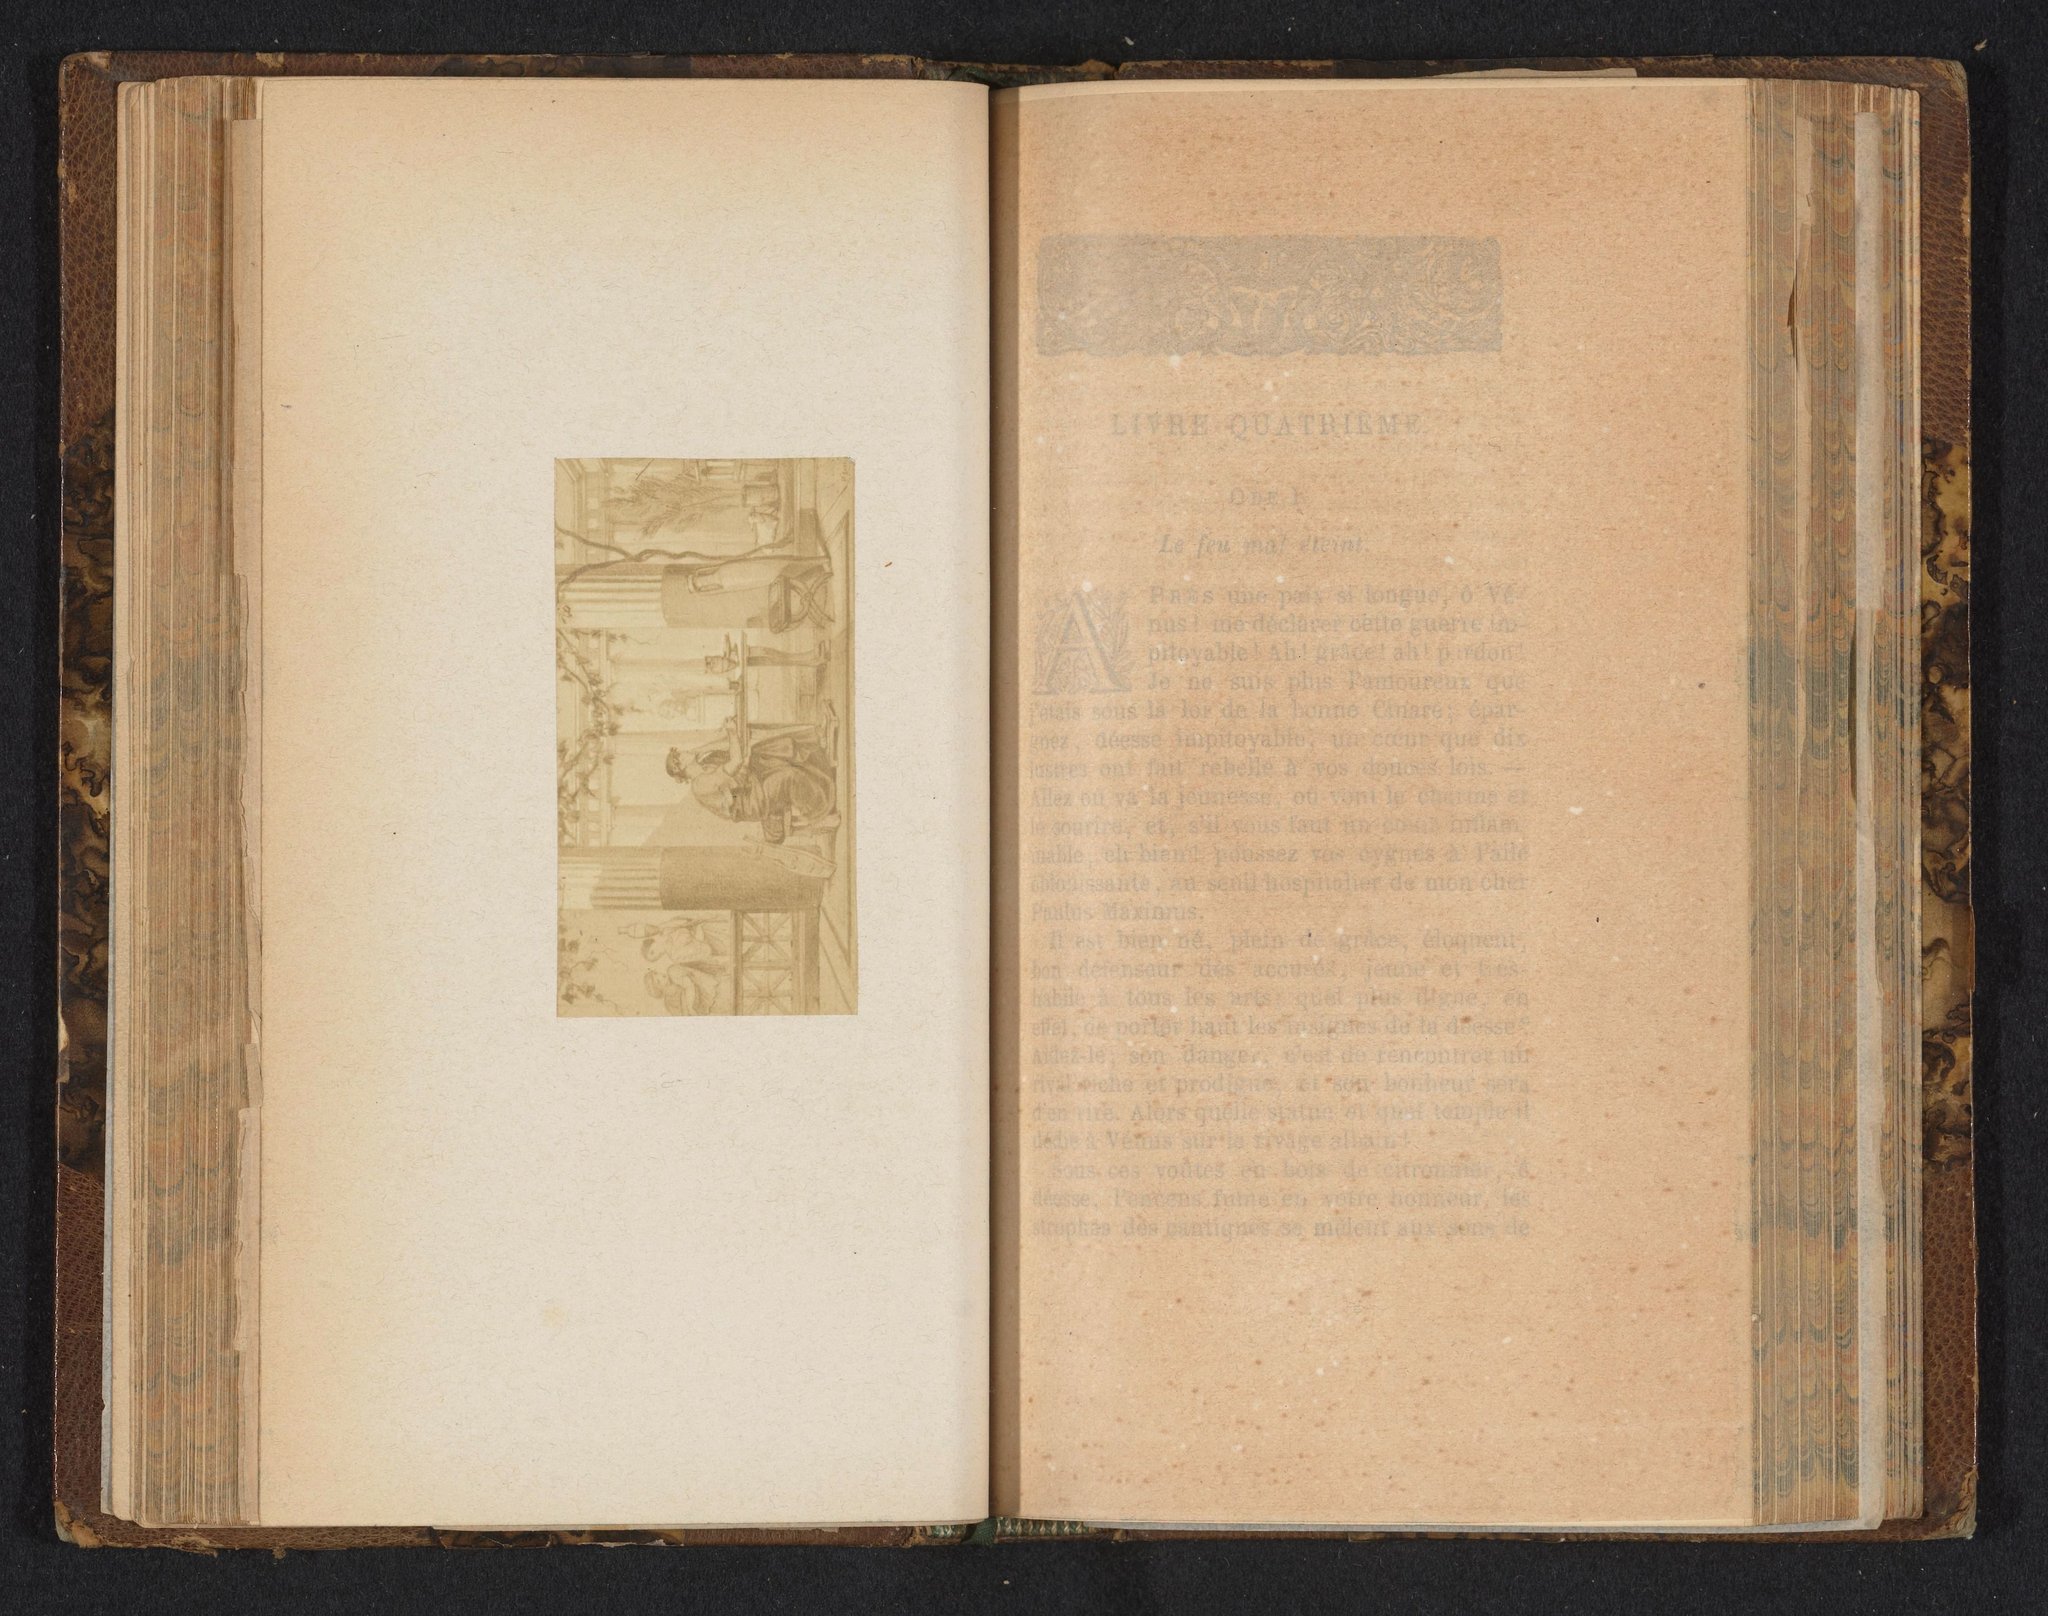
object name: page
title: Fotoreproductie van een schilderij, voorstellende een schrijver aan een tafel in een interieur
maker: Anonymous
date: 1851-1861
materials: photographic support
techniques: albumen print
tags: writing-table, writing-desk, handwriting, writing as activity, interior ~ representation of a building